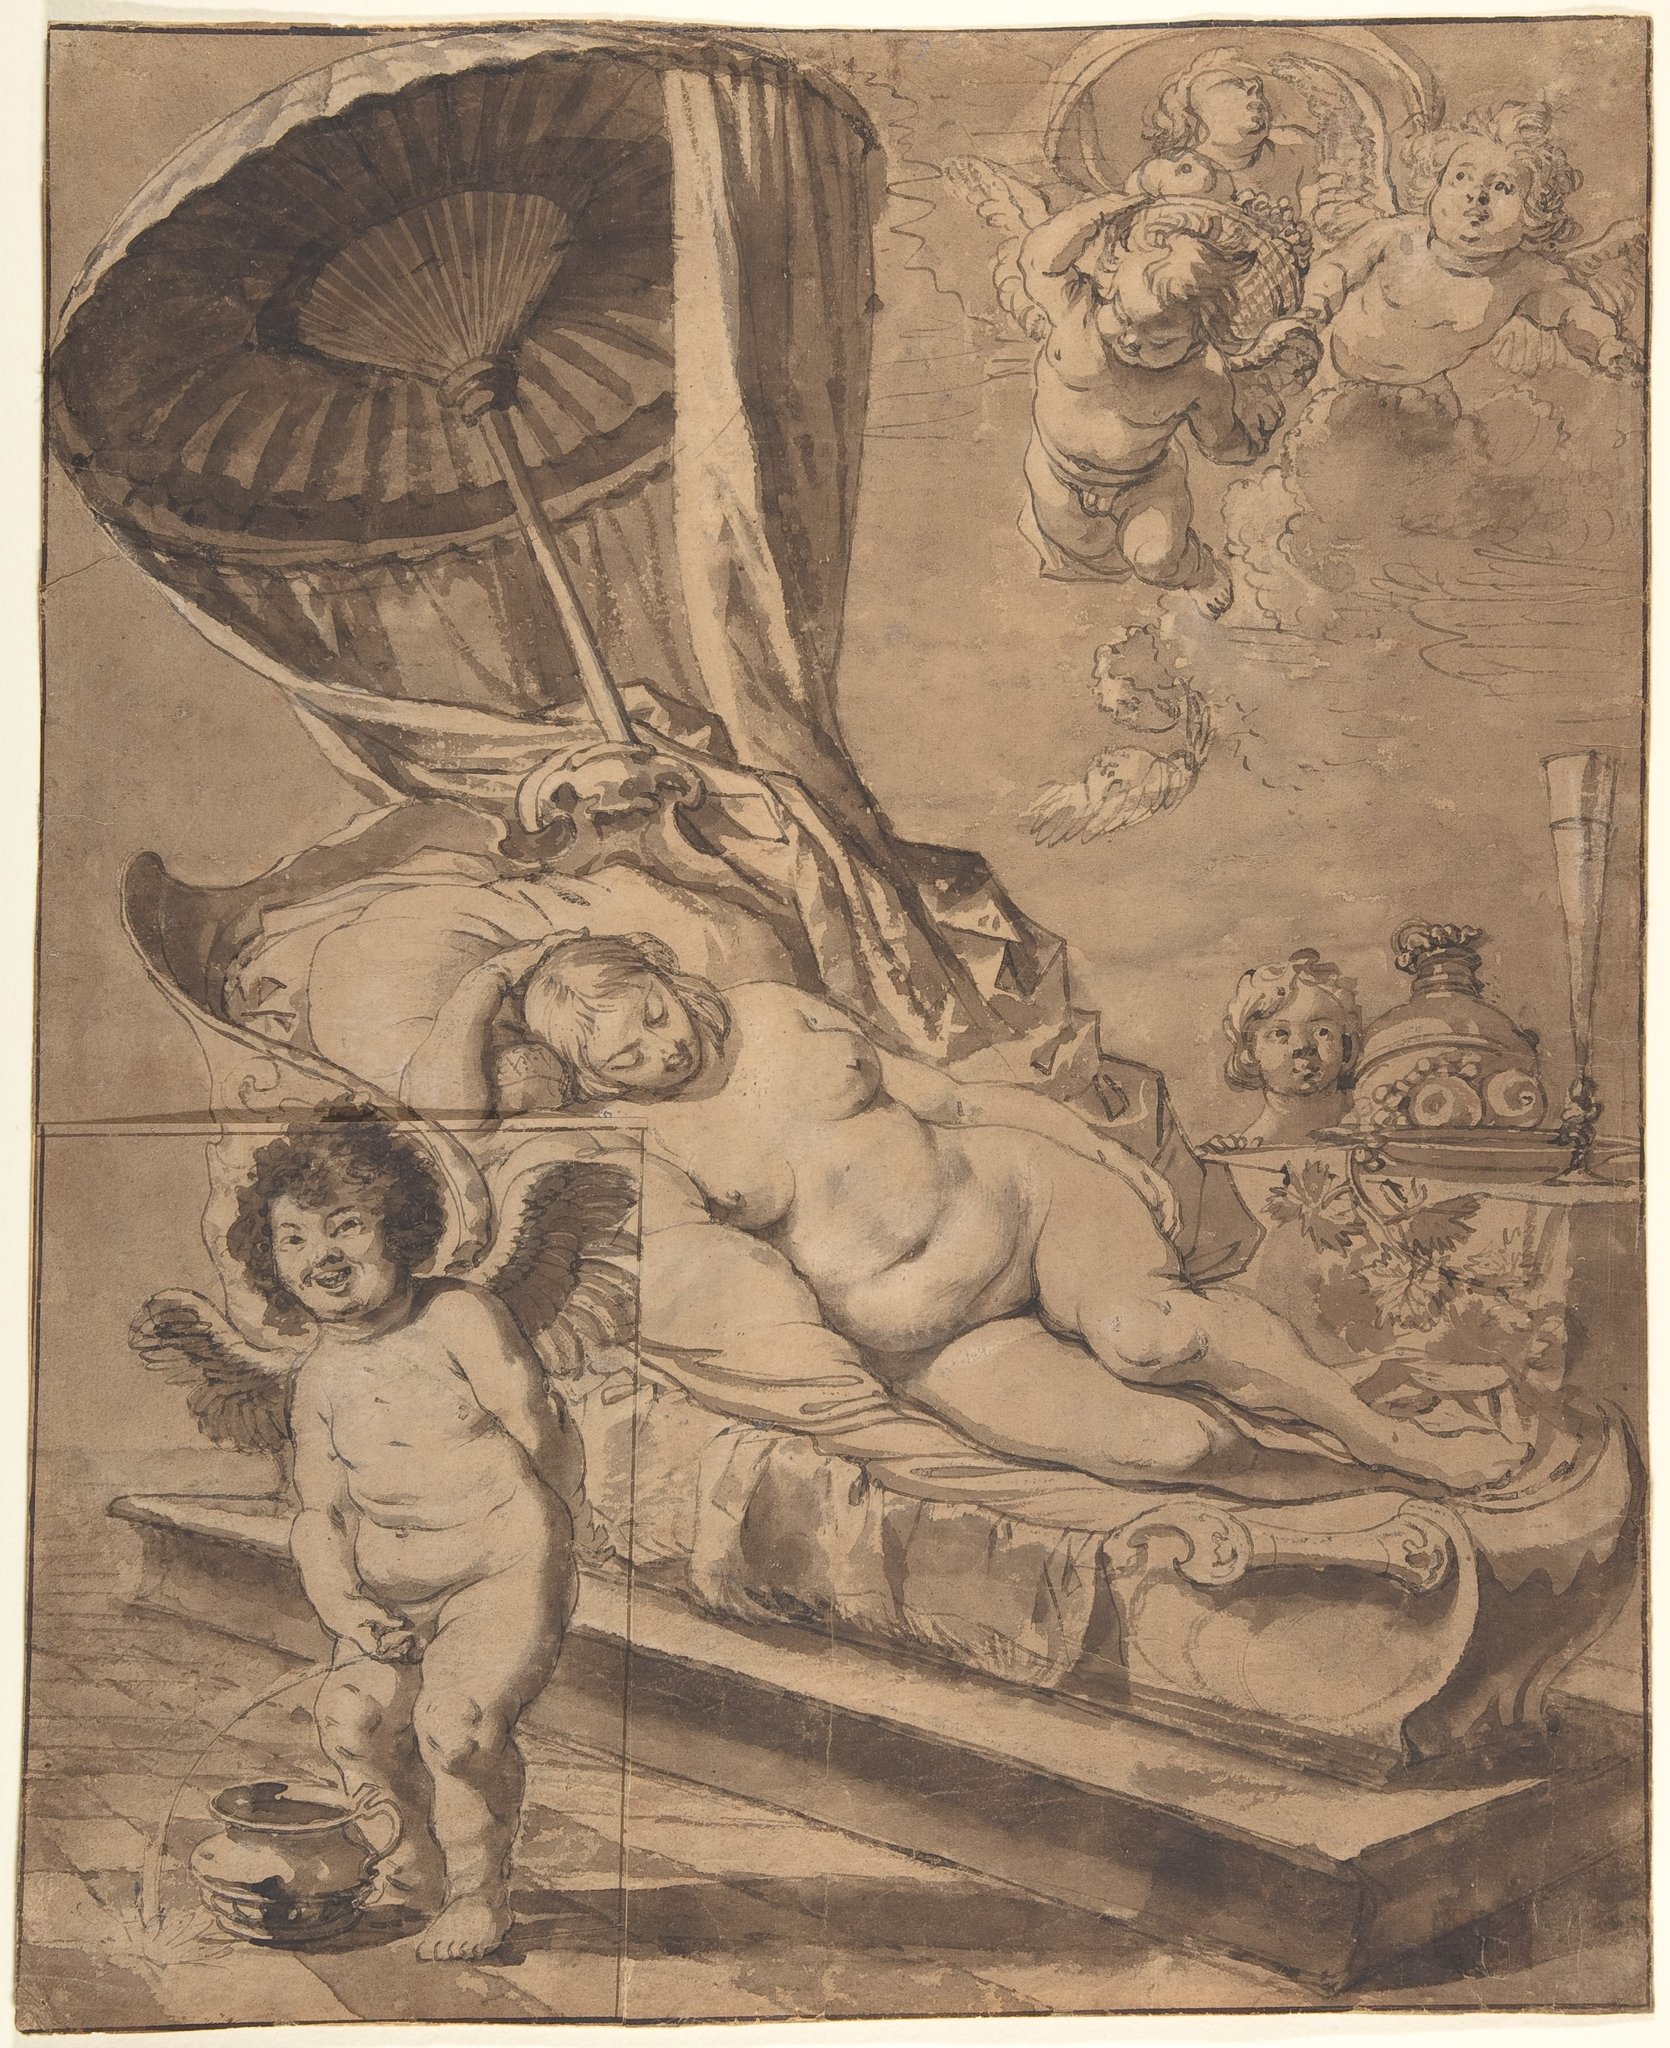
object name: drawing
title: Venus and Cupid (recto); Studies of a Woman (verso)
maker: nikolaus knüpfer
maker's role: artist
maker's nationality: german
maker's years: 1603-1655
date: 1620-1660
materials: ink, lead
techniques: brush, heightening, pen, wash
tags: female nudes,cupid,venus